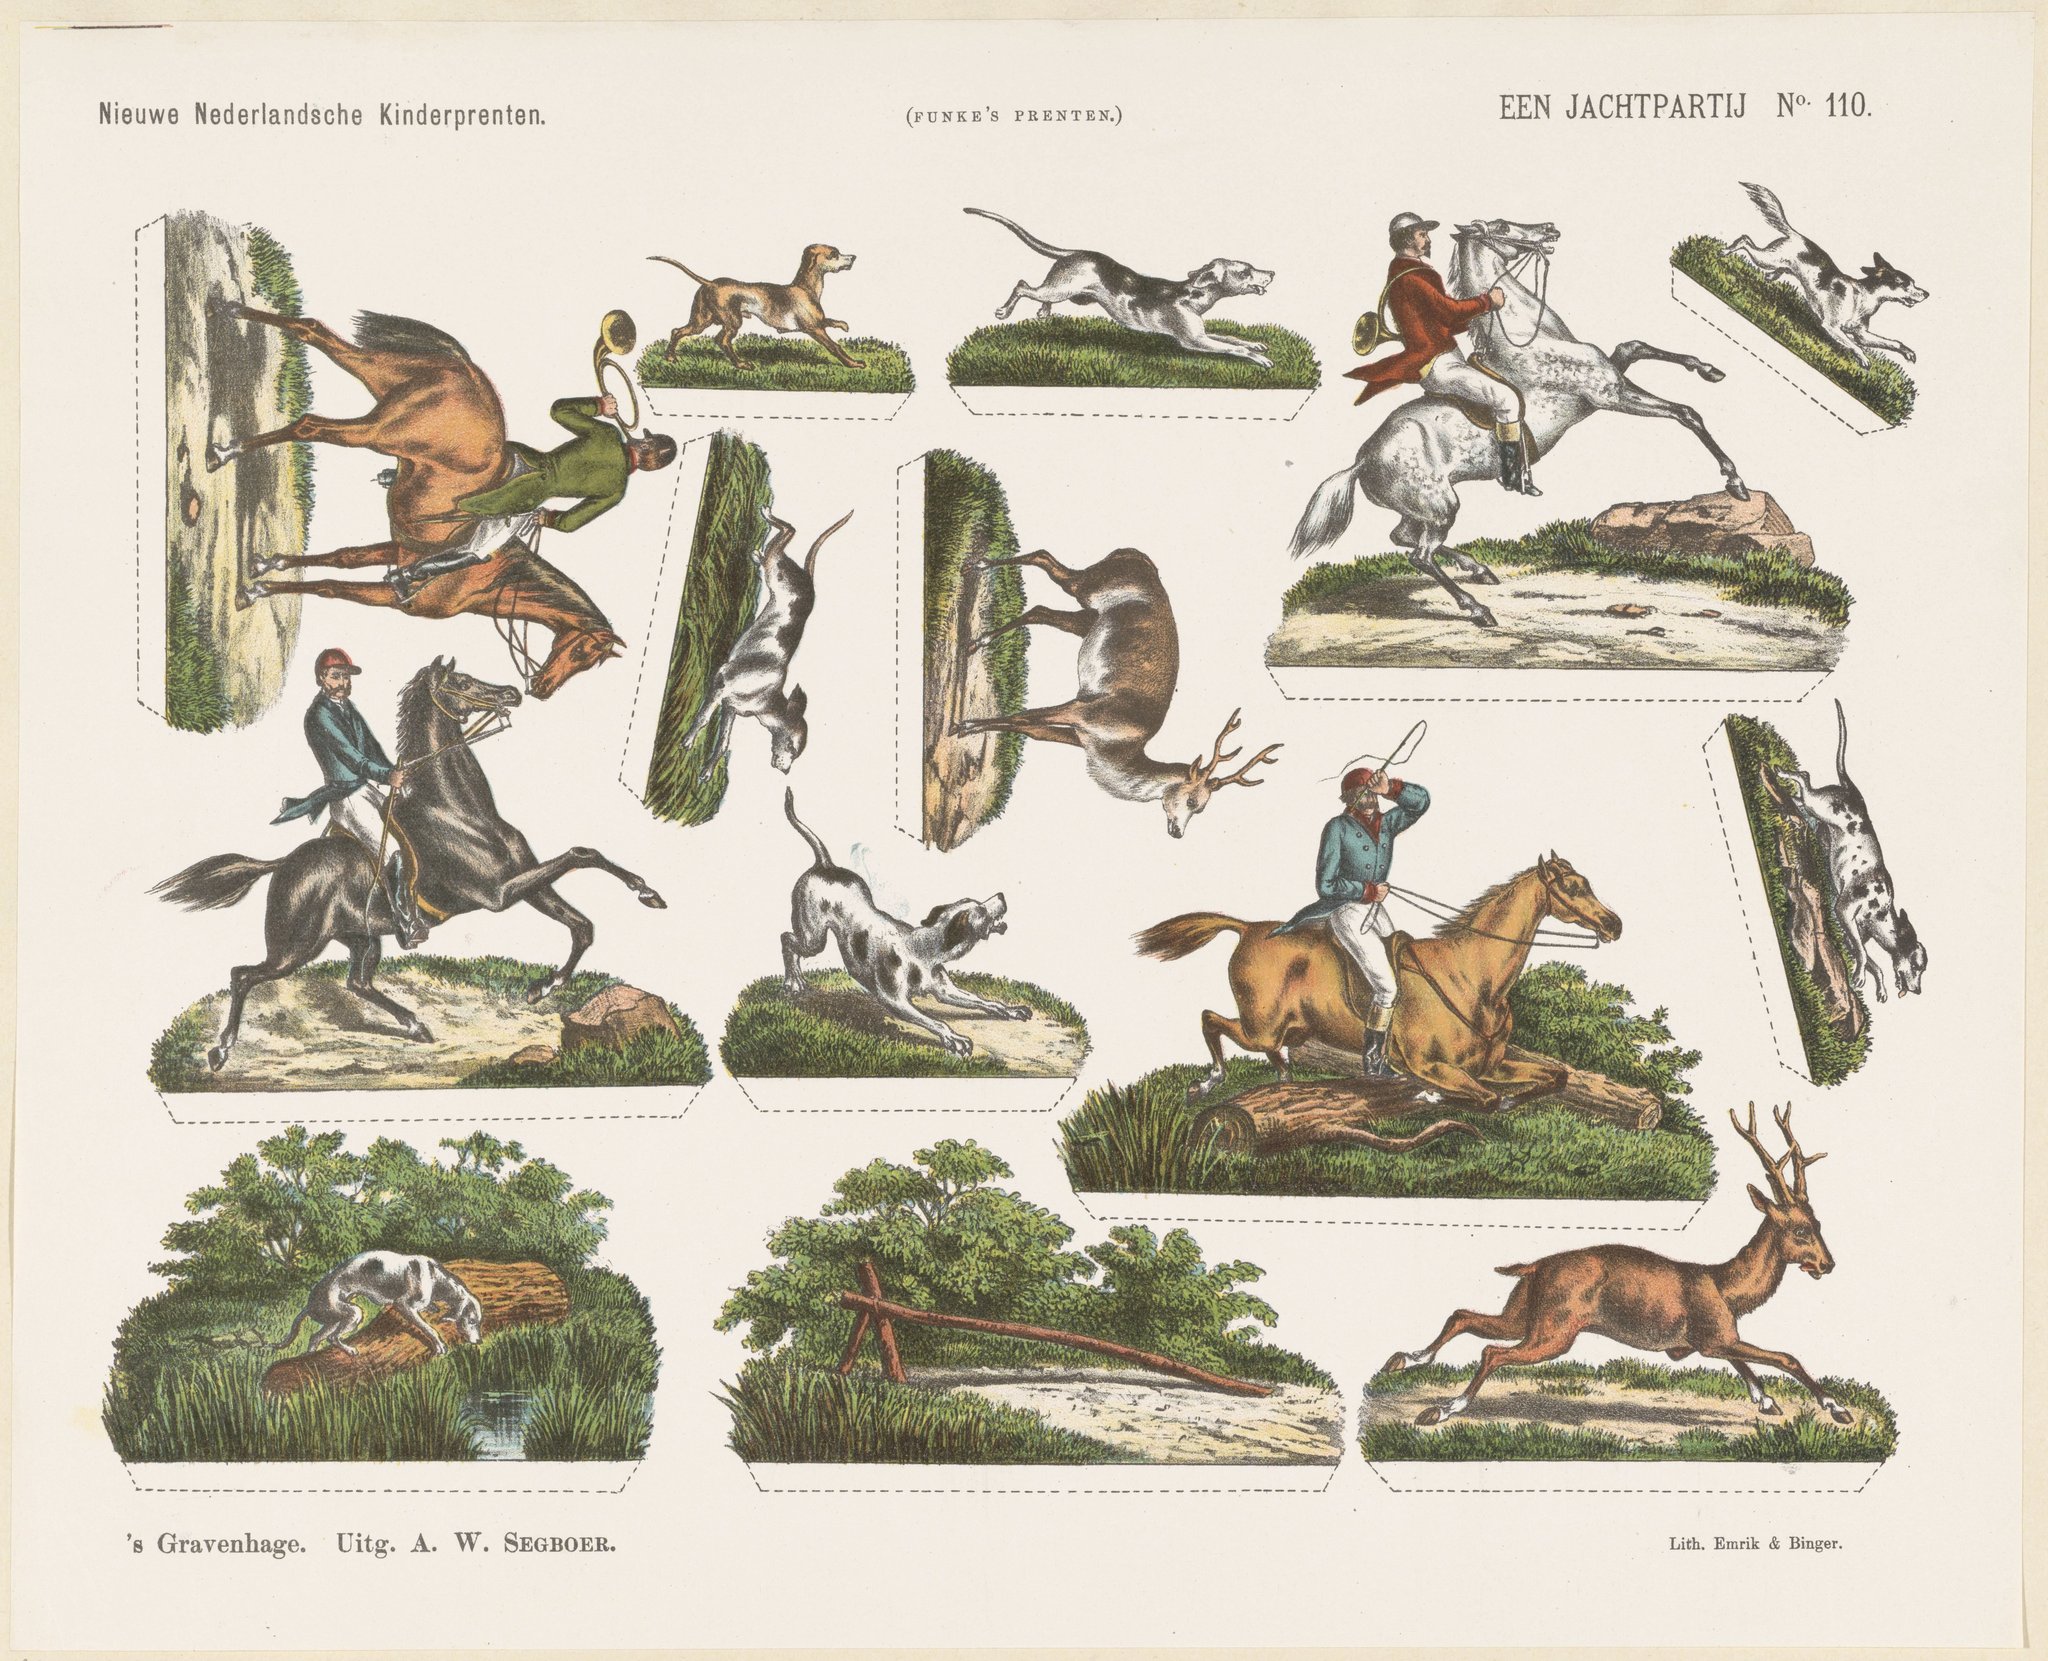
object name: print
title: Nieuwe Nederlandsche kinderprenten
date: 1903-1919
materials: paper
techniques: lithograph, letterpress printing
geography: the hague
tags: hunting dogs, hunter, hunters hunting (n.b.: in 1988-1990 this notation denoted the concept of 43c11421 'hunters resting during the hunt'), hunt ~ mammals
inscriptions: collector's mark: Lugt 2760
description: Blad met 14 voorstellingen van jagers te paard, jachthonden en herten om uit te knippen. Genummerd rechtsboven: No. 110.